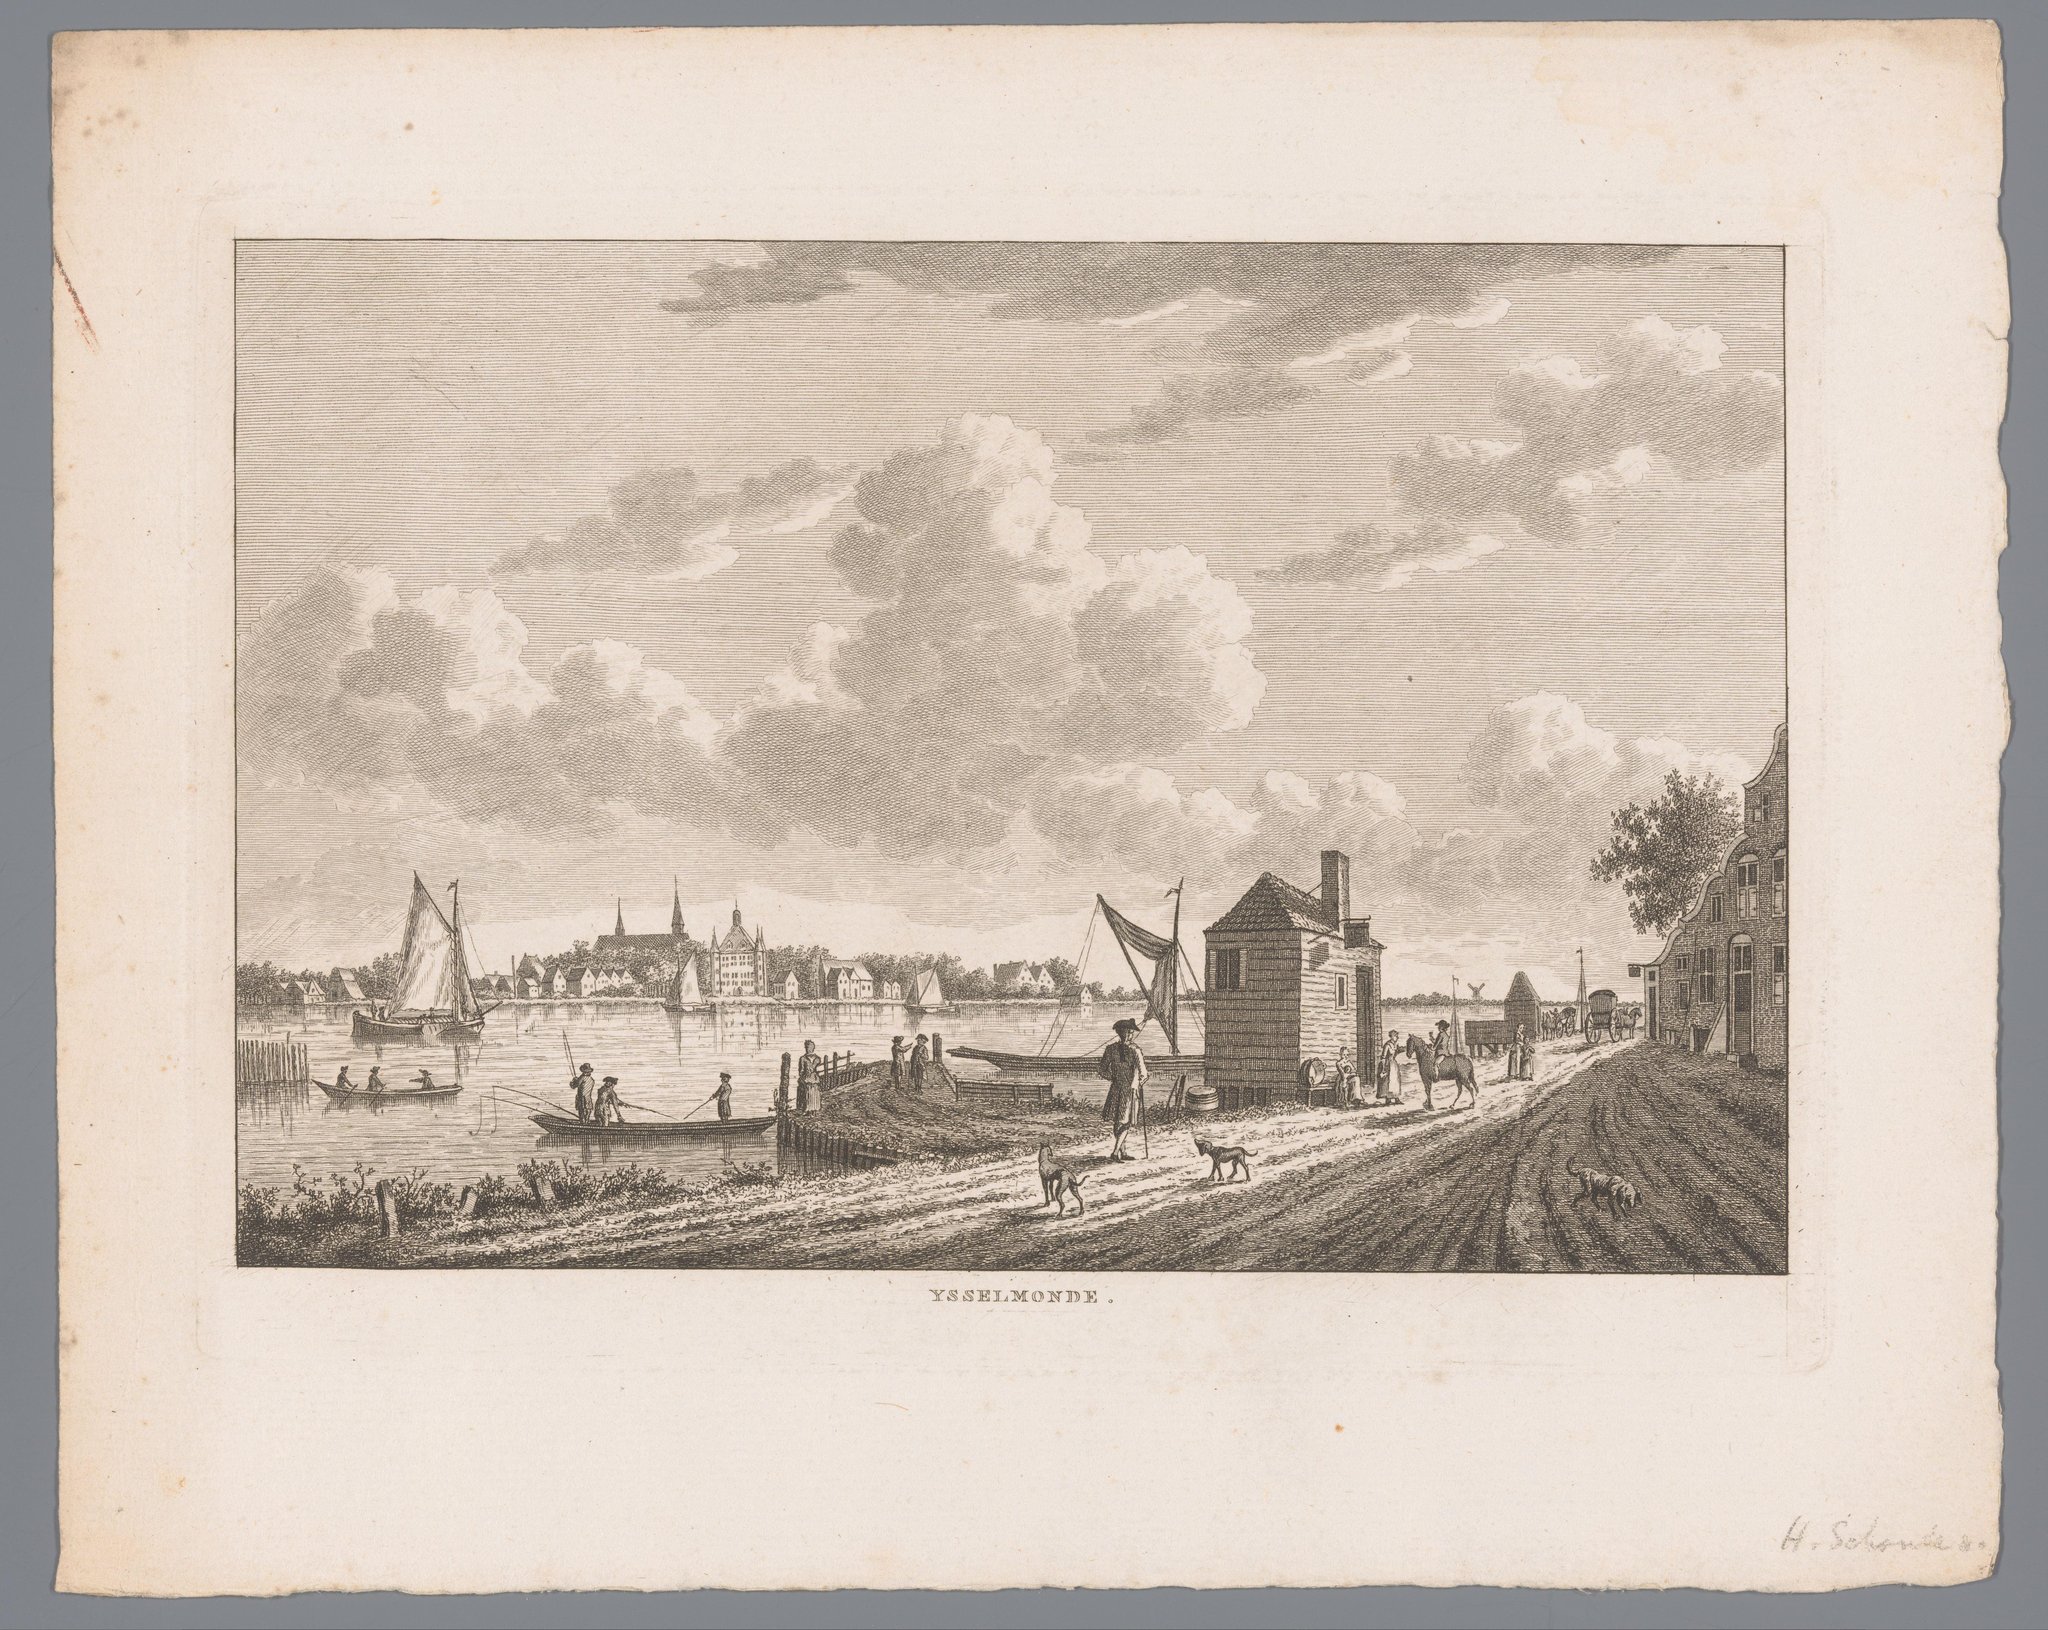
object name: print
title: Gezicht op IJsselmonde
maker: carel frederik bendorp (i)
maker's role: print maker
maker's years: 1736-1814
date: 1786-1792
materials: paper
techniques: etching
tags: prospect of village, silhouette of village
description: Prent uit: Vaderlandsche gezichten, of afbeeldingen van den tegenwoordigen staat der Vereenigde Nederlanden (…). Amsterdam: Hendrik Gartman, Willem Vermandel en Jan Willem Smit, 1786-1792. Uitgegeven in afleveringen met ieder een eigen bifolium en inhoudsopgave. Alle prenten in deze publicatie zijn gegraveerd door Carel Frederik Bendorp (I) en, in de meeste gevallen, gebaseerd op tekeningen van Jan Bulthuis.